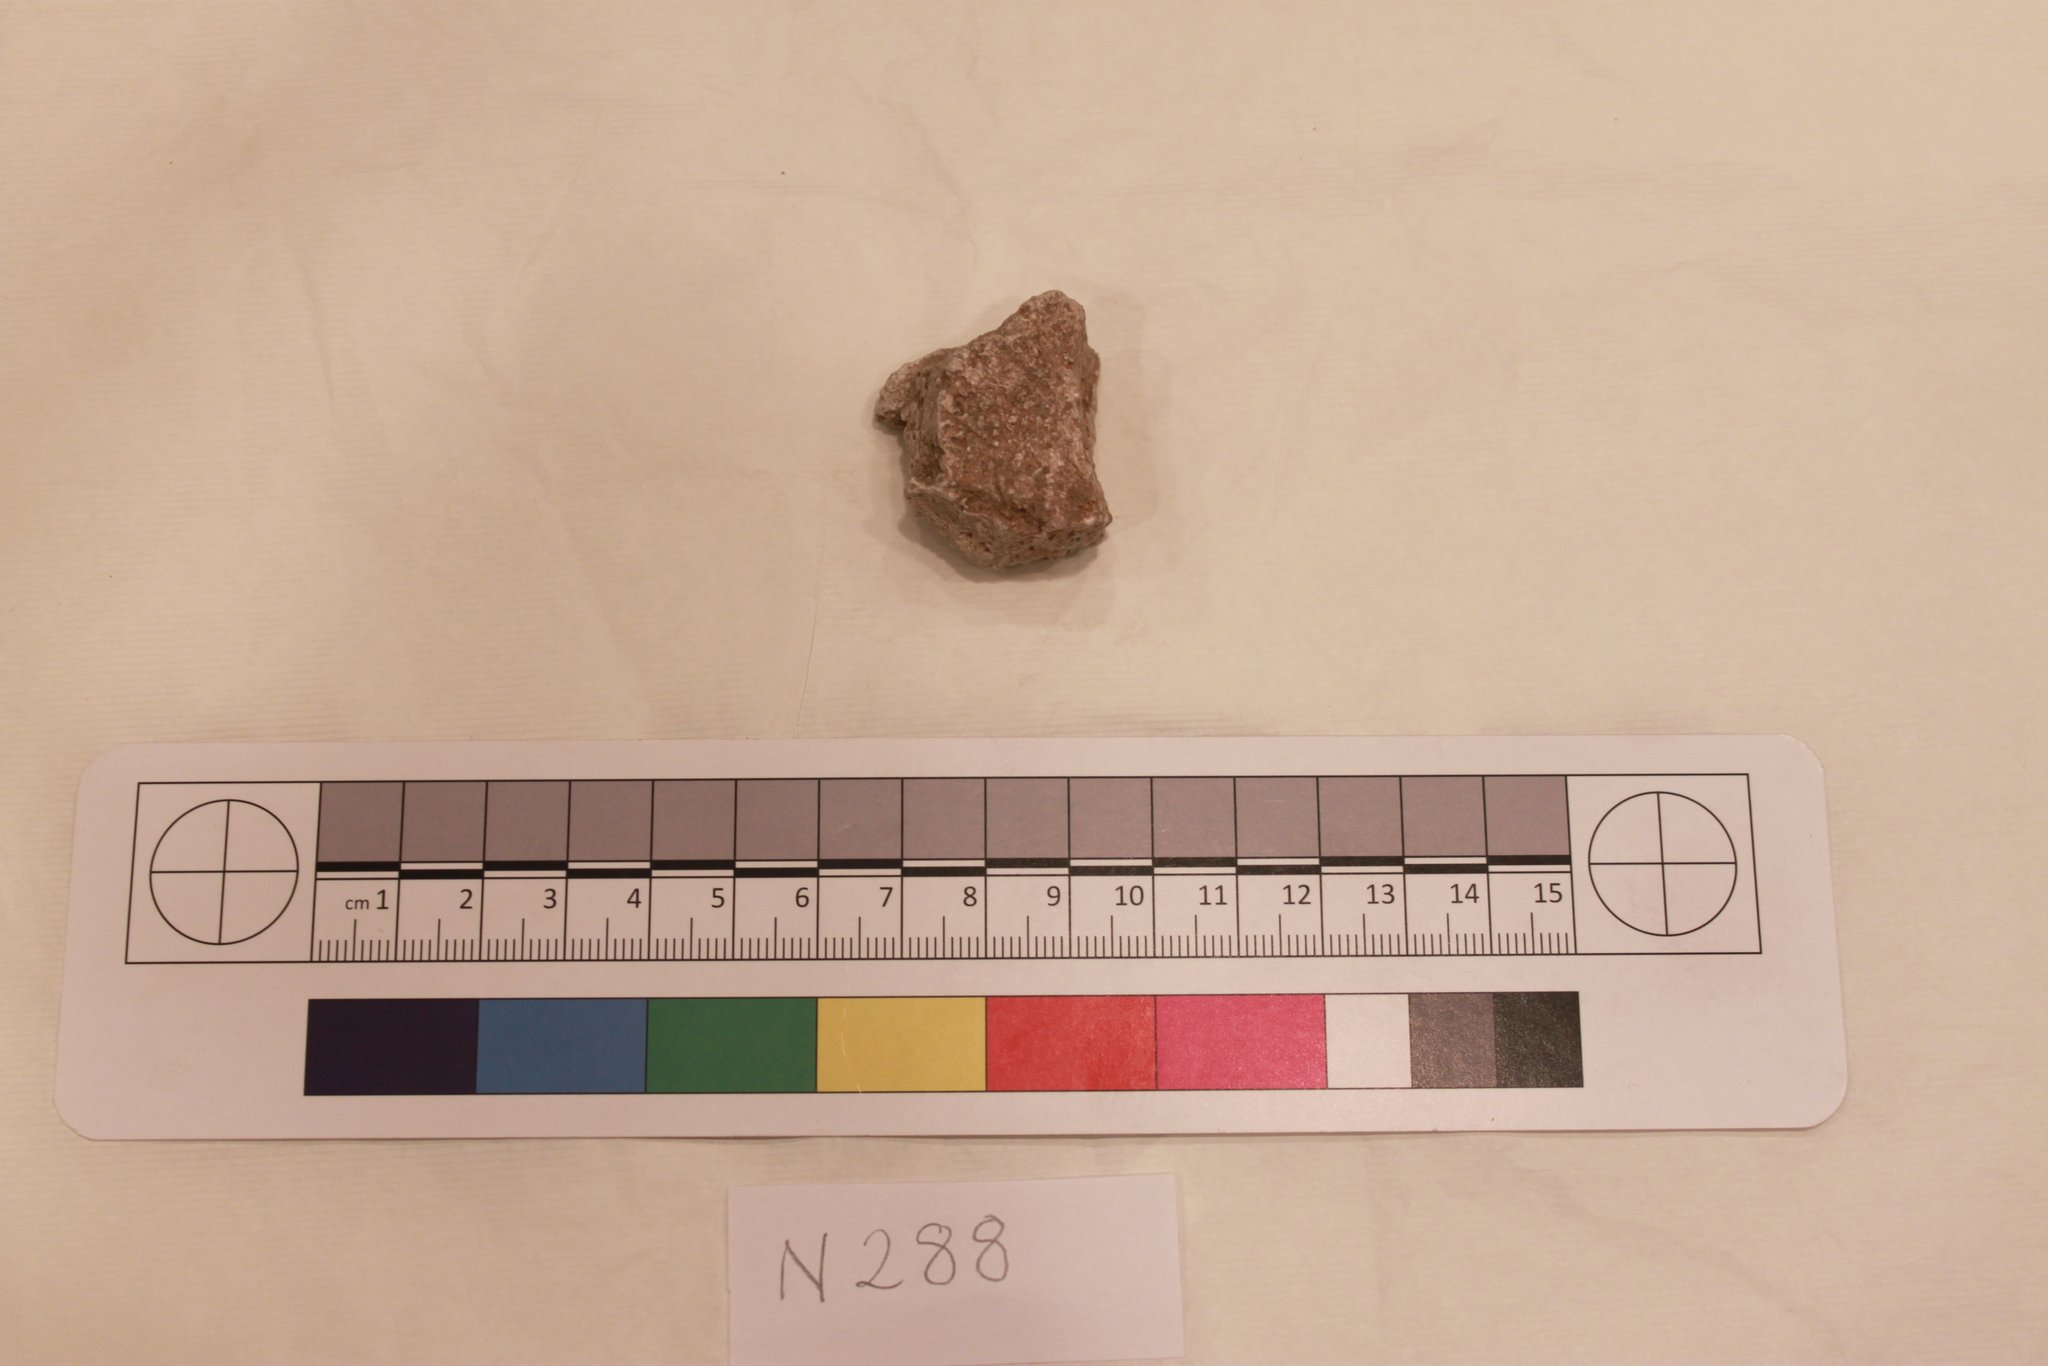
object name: fragment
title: Stucco Fragment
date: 701-1200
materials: plaster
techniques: carving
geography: iran